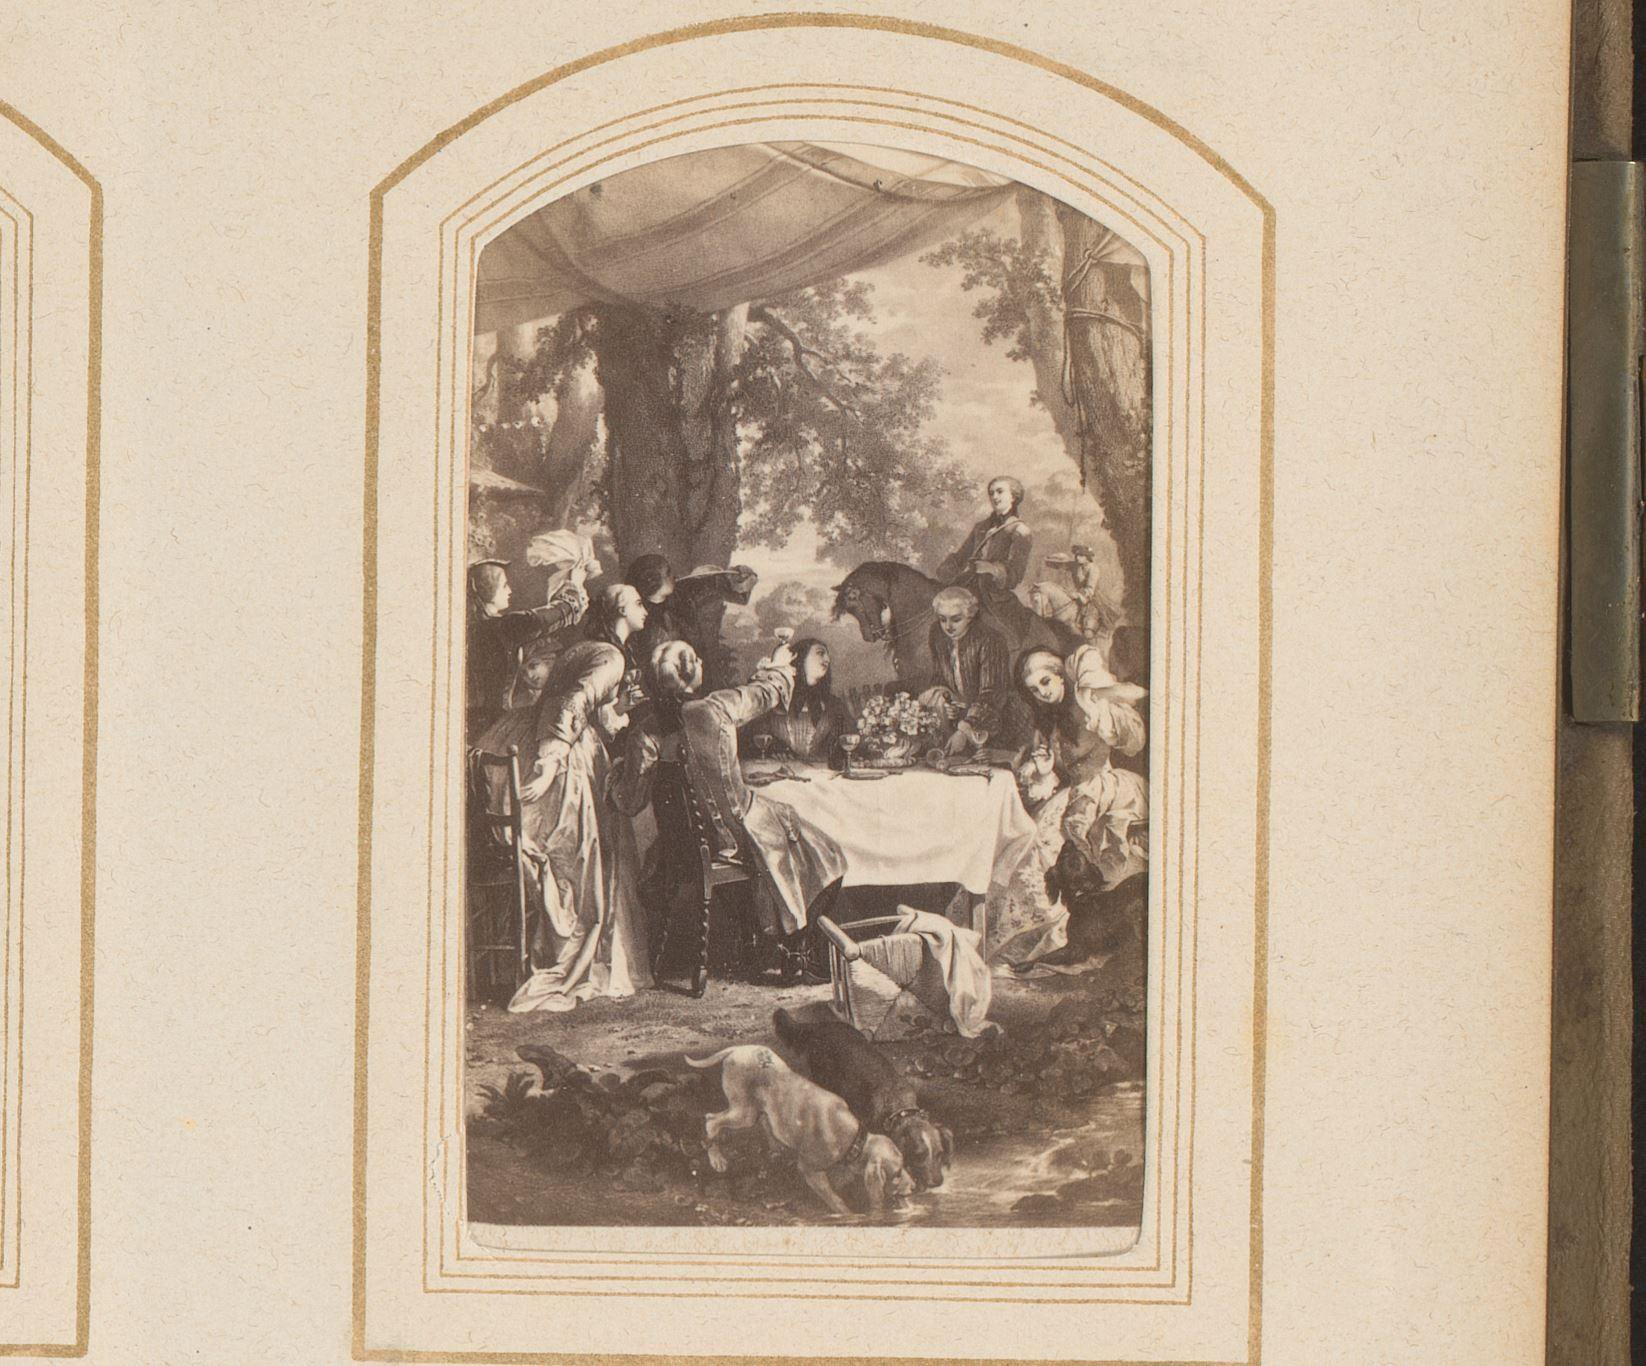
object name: photograph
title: Fotoreproductie van L'automne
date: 1870-1890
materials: cardboard, photographic support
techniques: albumen print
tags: garden, painting, drawing and the graphic arts, private festivities, merry company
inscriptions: annotation: ‘Herbst’, inscription: ‘Jourdan, 50. L'automne’